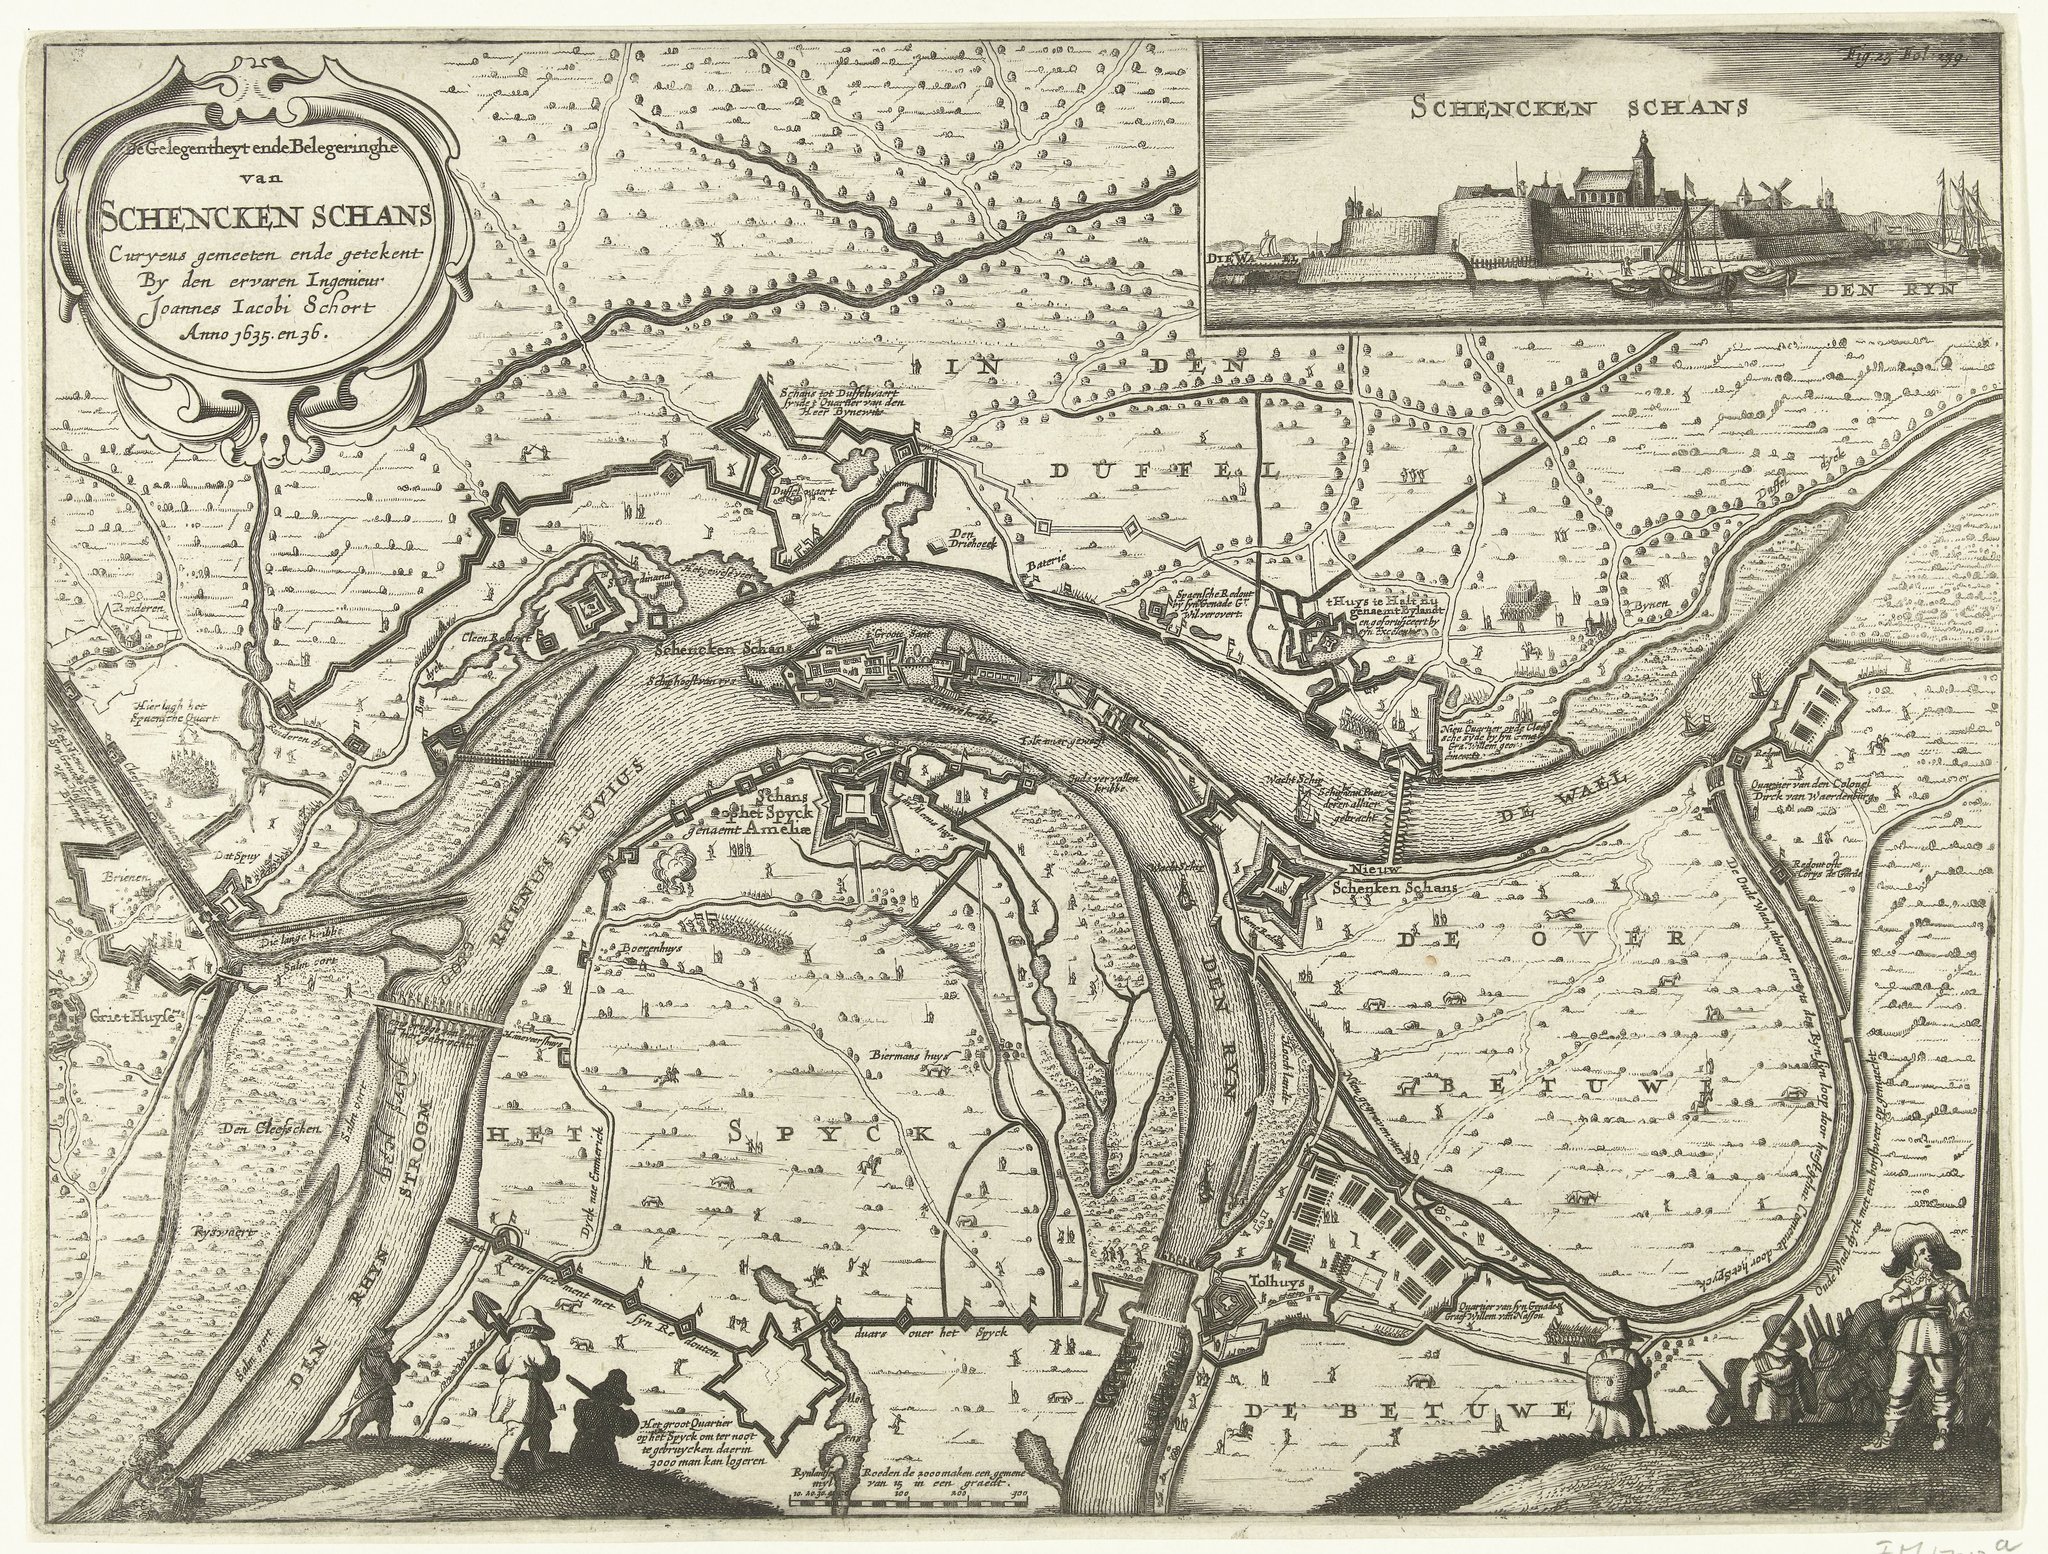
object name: history print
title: Kaart met beleg en verovering van Schenkenschans door Frederik Hendrik, 1635-1636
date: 1651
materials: paper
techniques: engraving, etching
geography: northern netherlands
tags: delft, the hague, frederick henry (prince of orange), maps of separate countries or regions, siege, position war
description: Kaart van het beleg en de inname van Schenkenschans door het Staatse leger onder Frederik Hendrik, 1635-1636. Linksboven de titelcartouche. Rechtsboven een aanzicht van het fort vanaf het water. Onderaan op de voorgrond verschillende figuurtjes. Onderaan in het midden een schaalstok: Rynlantse roeden de 2000 maken een gemene myl van 15 in een graedt. Gemerkt rechtsboven: Fig. 25 Fol. 239.